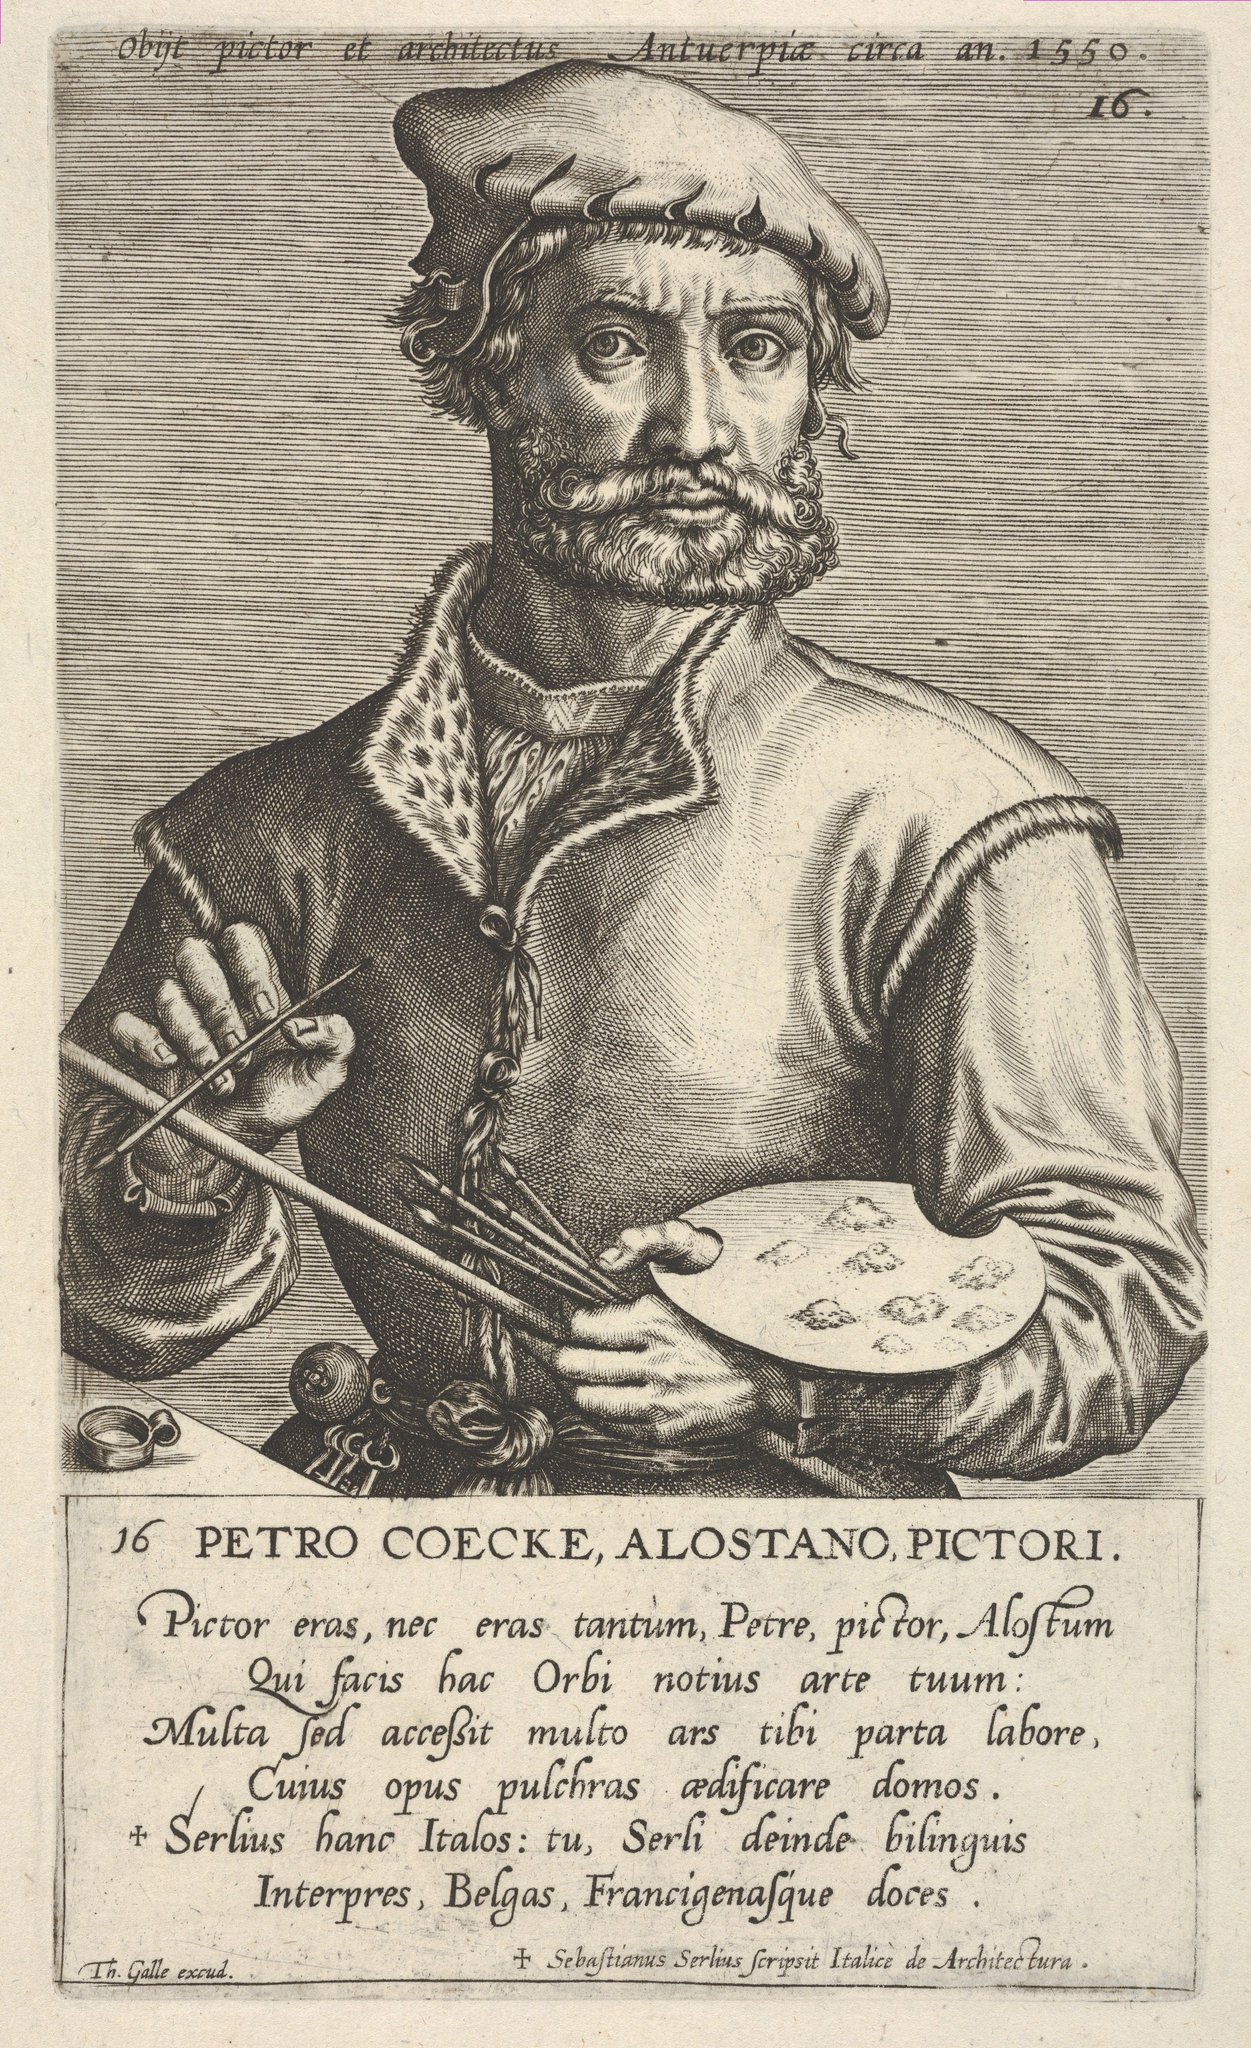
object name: print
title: Pieter Coecke van Aelst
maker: jan (johannes) wierix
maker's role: artist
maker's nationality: netherlandish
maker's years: 1549-1615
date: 1563-1615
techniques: engraving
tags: painting,men,portraits,artists,palettes